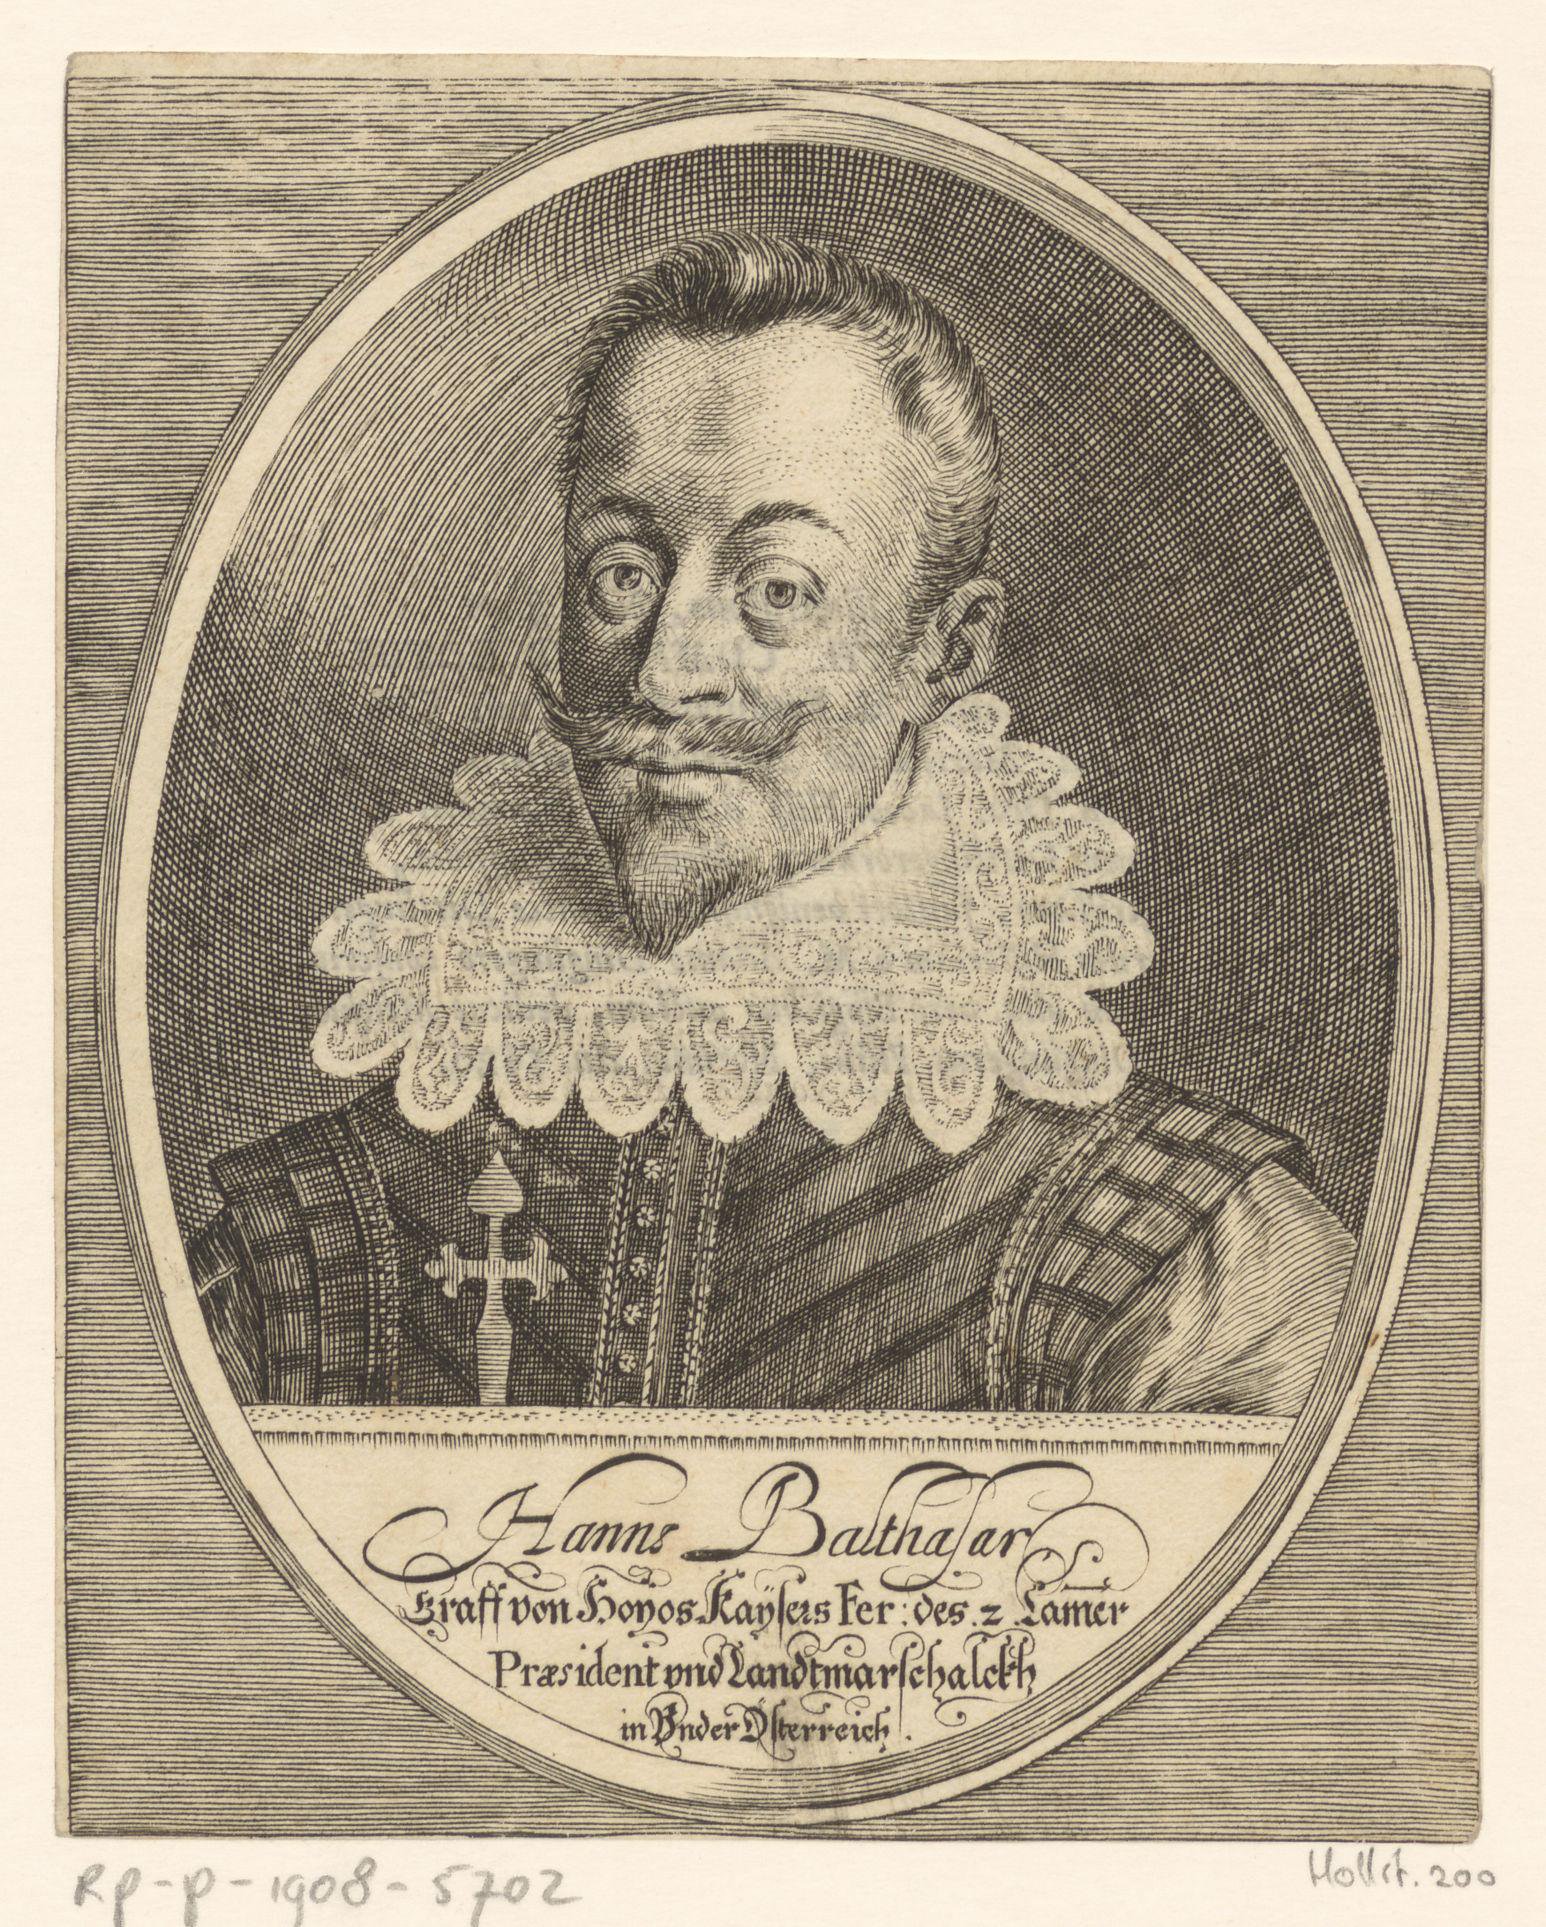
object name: print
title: Portret van Hans Balthasar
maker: wolfgang kilian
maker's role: print maker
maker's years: 1581-1662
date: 1591-1662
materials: paper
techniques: engraving, etching, letterpress printing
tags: earl, historical persons, ruler, sovereign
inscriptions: collector's mark: Lugt 2228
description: Tekst in het Duits in de ondermarge en informatie over de geportretteerde in het Latijn in boekdruk op verso.